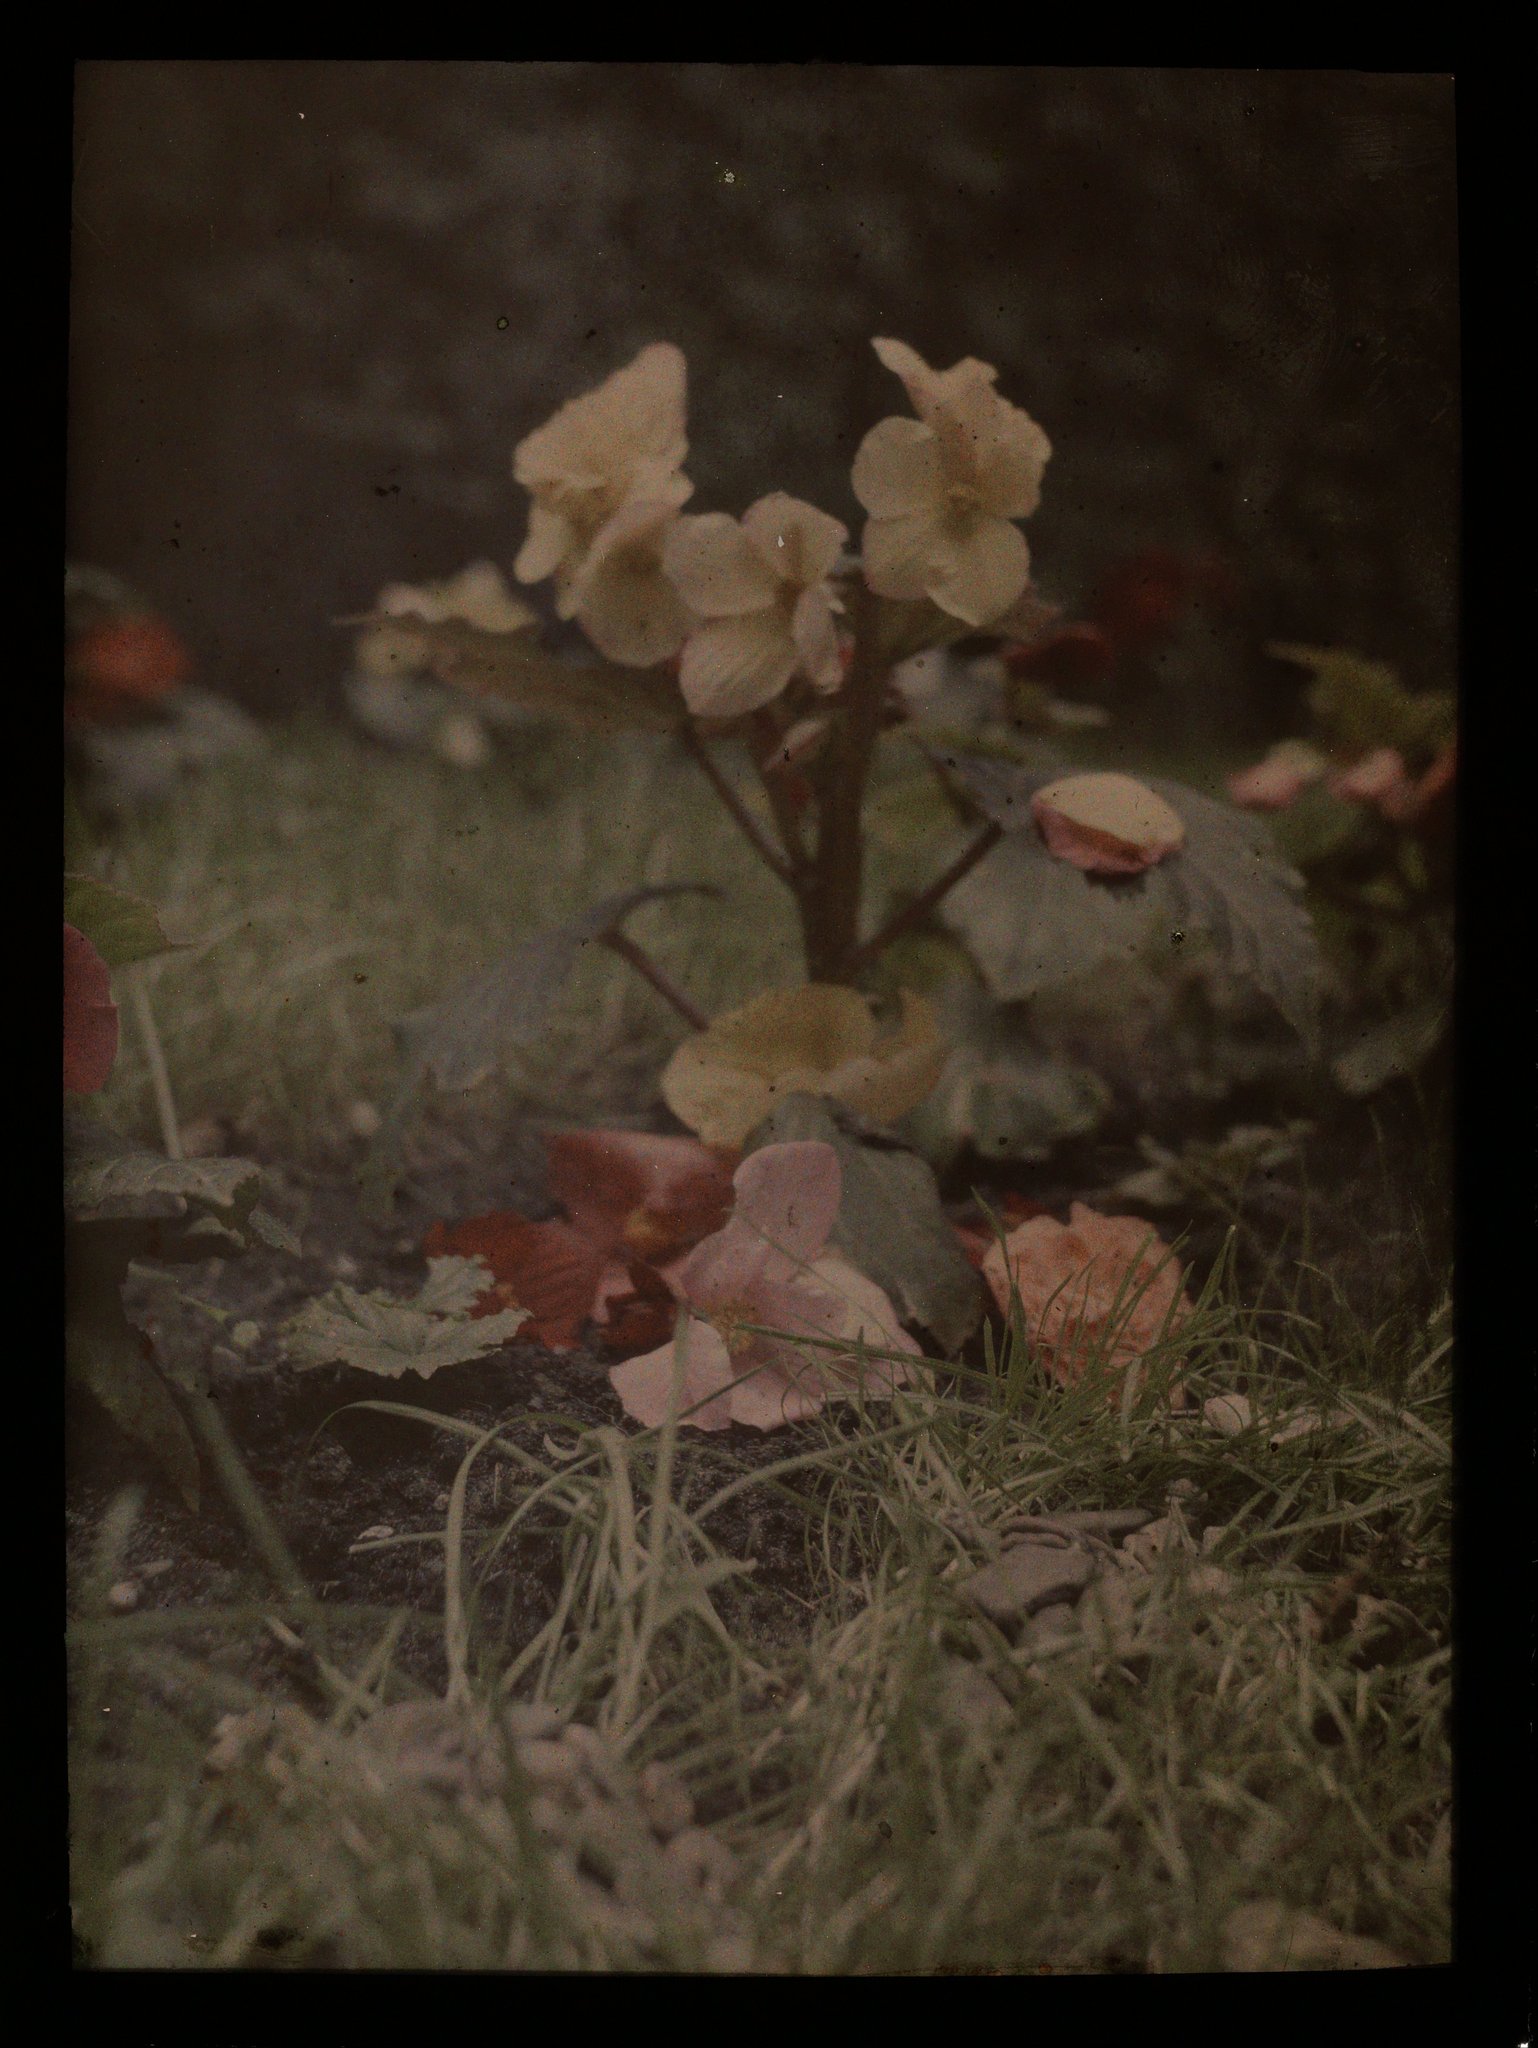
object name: photograph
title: Bloeiende tuinplant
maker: Anonymous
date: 1907-1935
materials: glass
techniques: autochrome process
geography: netherlands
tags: flowers, garden, netherlands